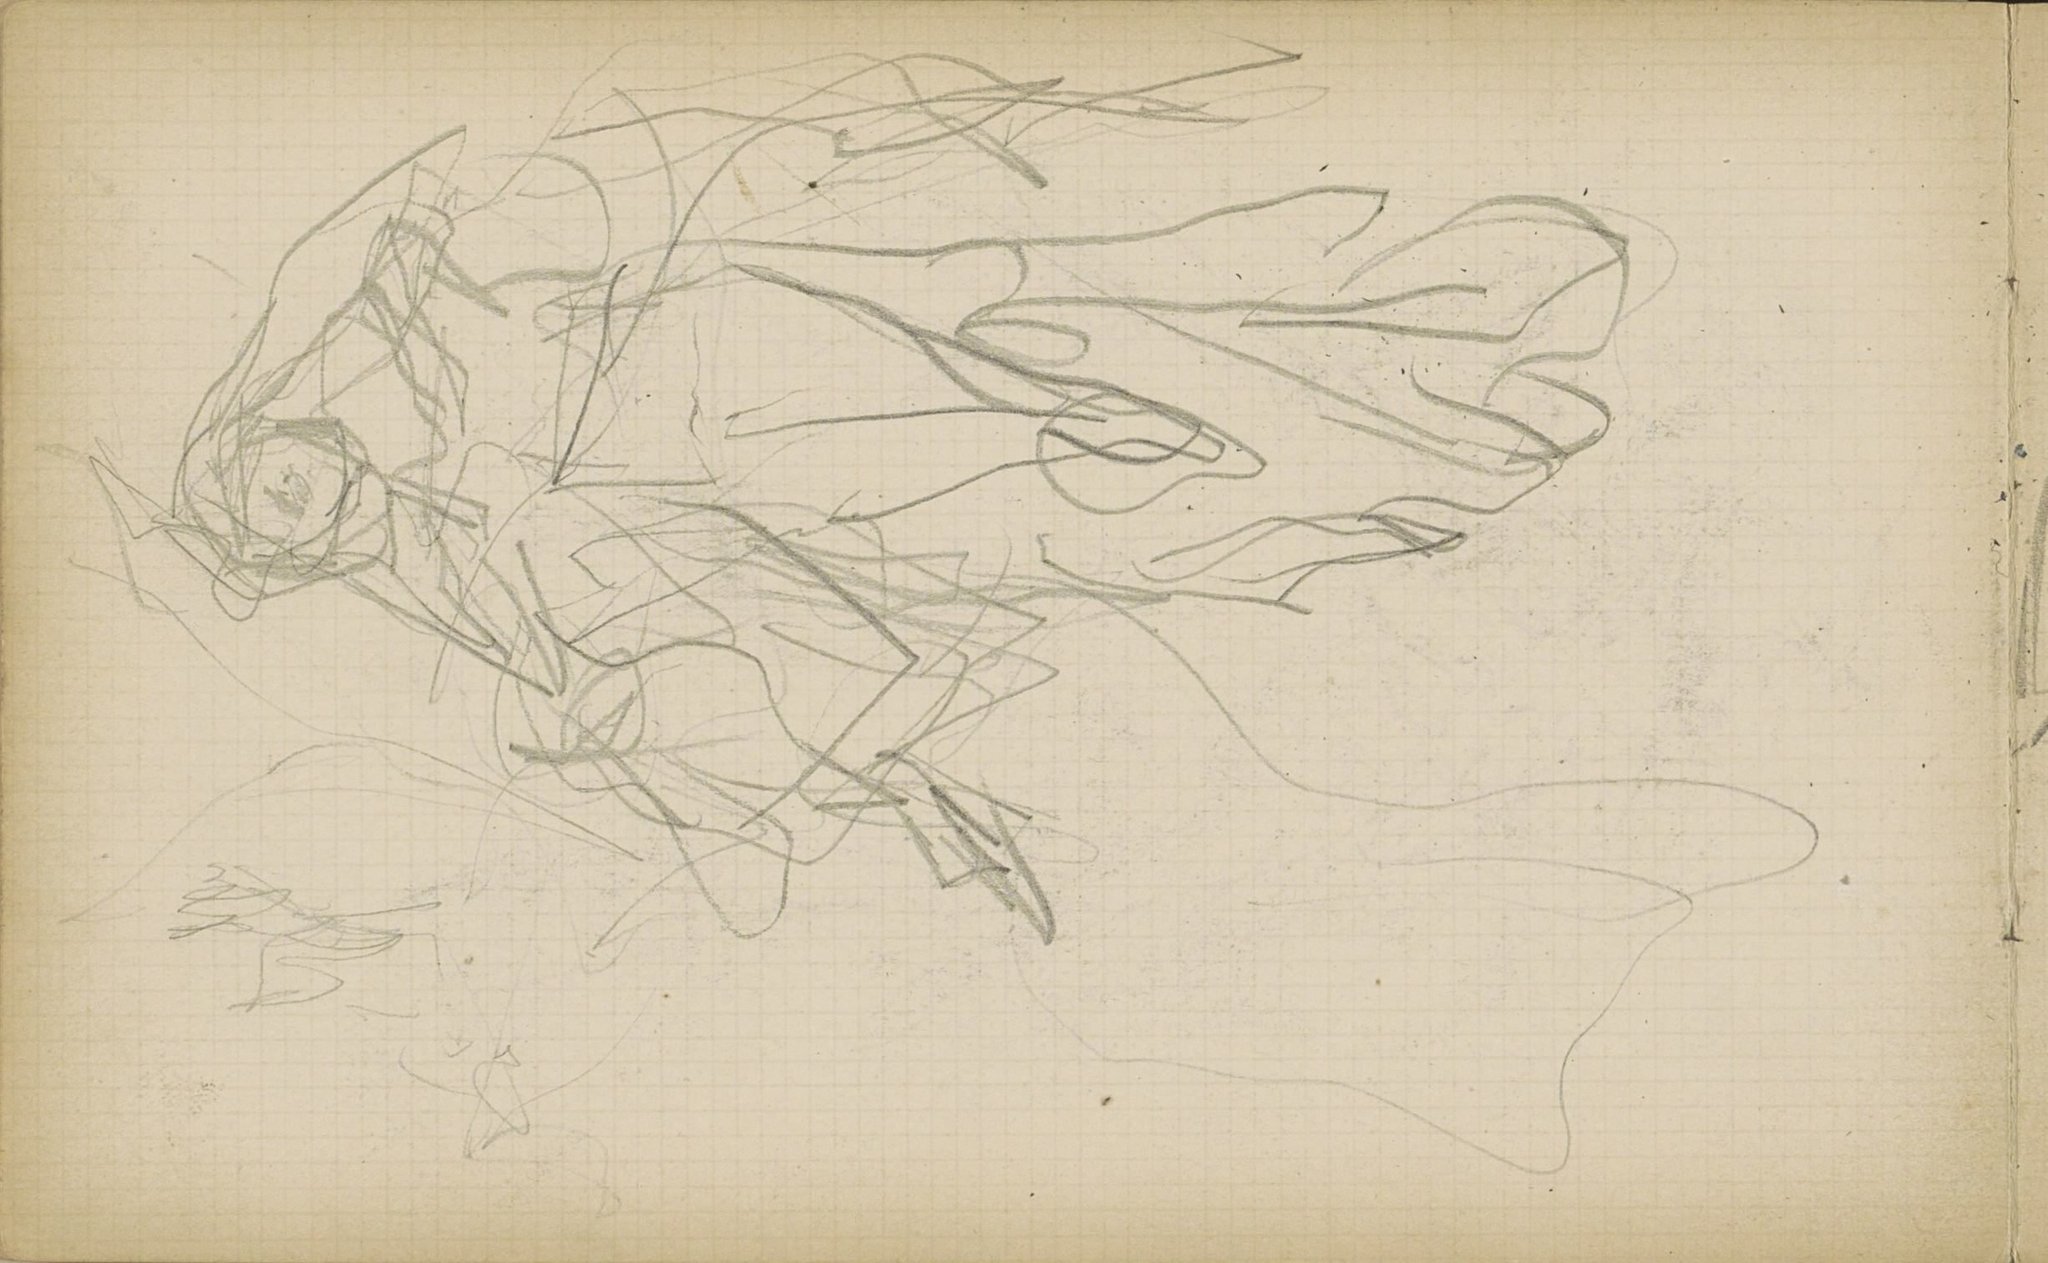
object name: sketchbook leaf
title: Staande vrouw in een lang gewaad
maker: matthijs maris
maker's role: draughtsman, painter, print maker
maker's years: 1839-1917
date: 1849-1917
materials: pencil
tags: standing figure (+ female (human being) (not to be used where -aa- is prescribed)), clothes, costume (+ women's clothes)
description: Blad 9 verso uit een schetsboek met 35 bladen.